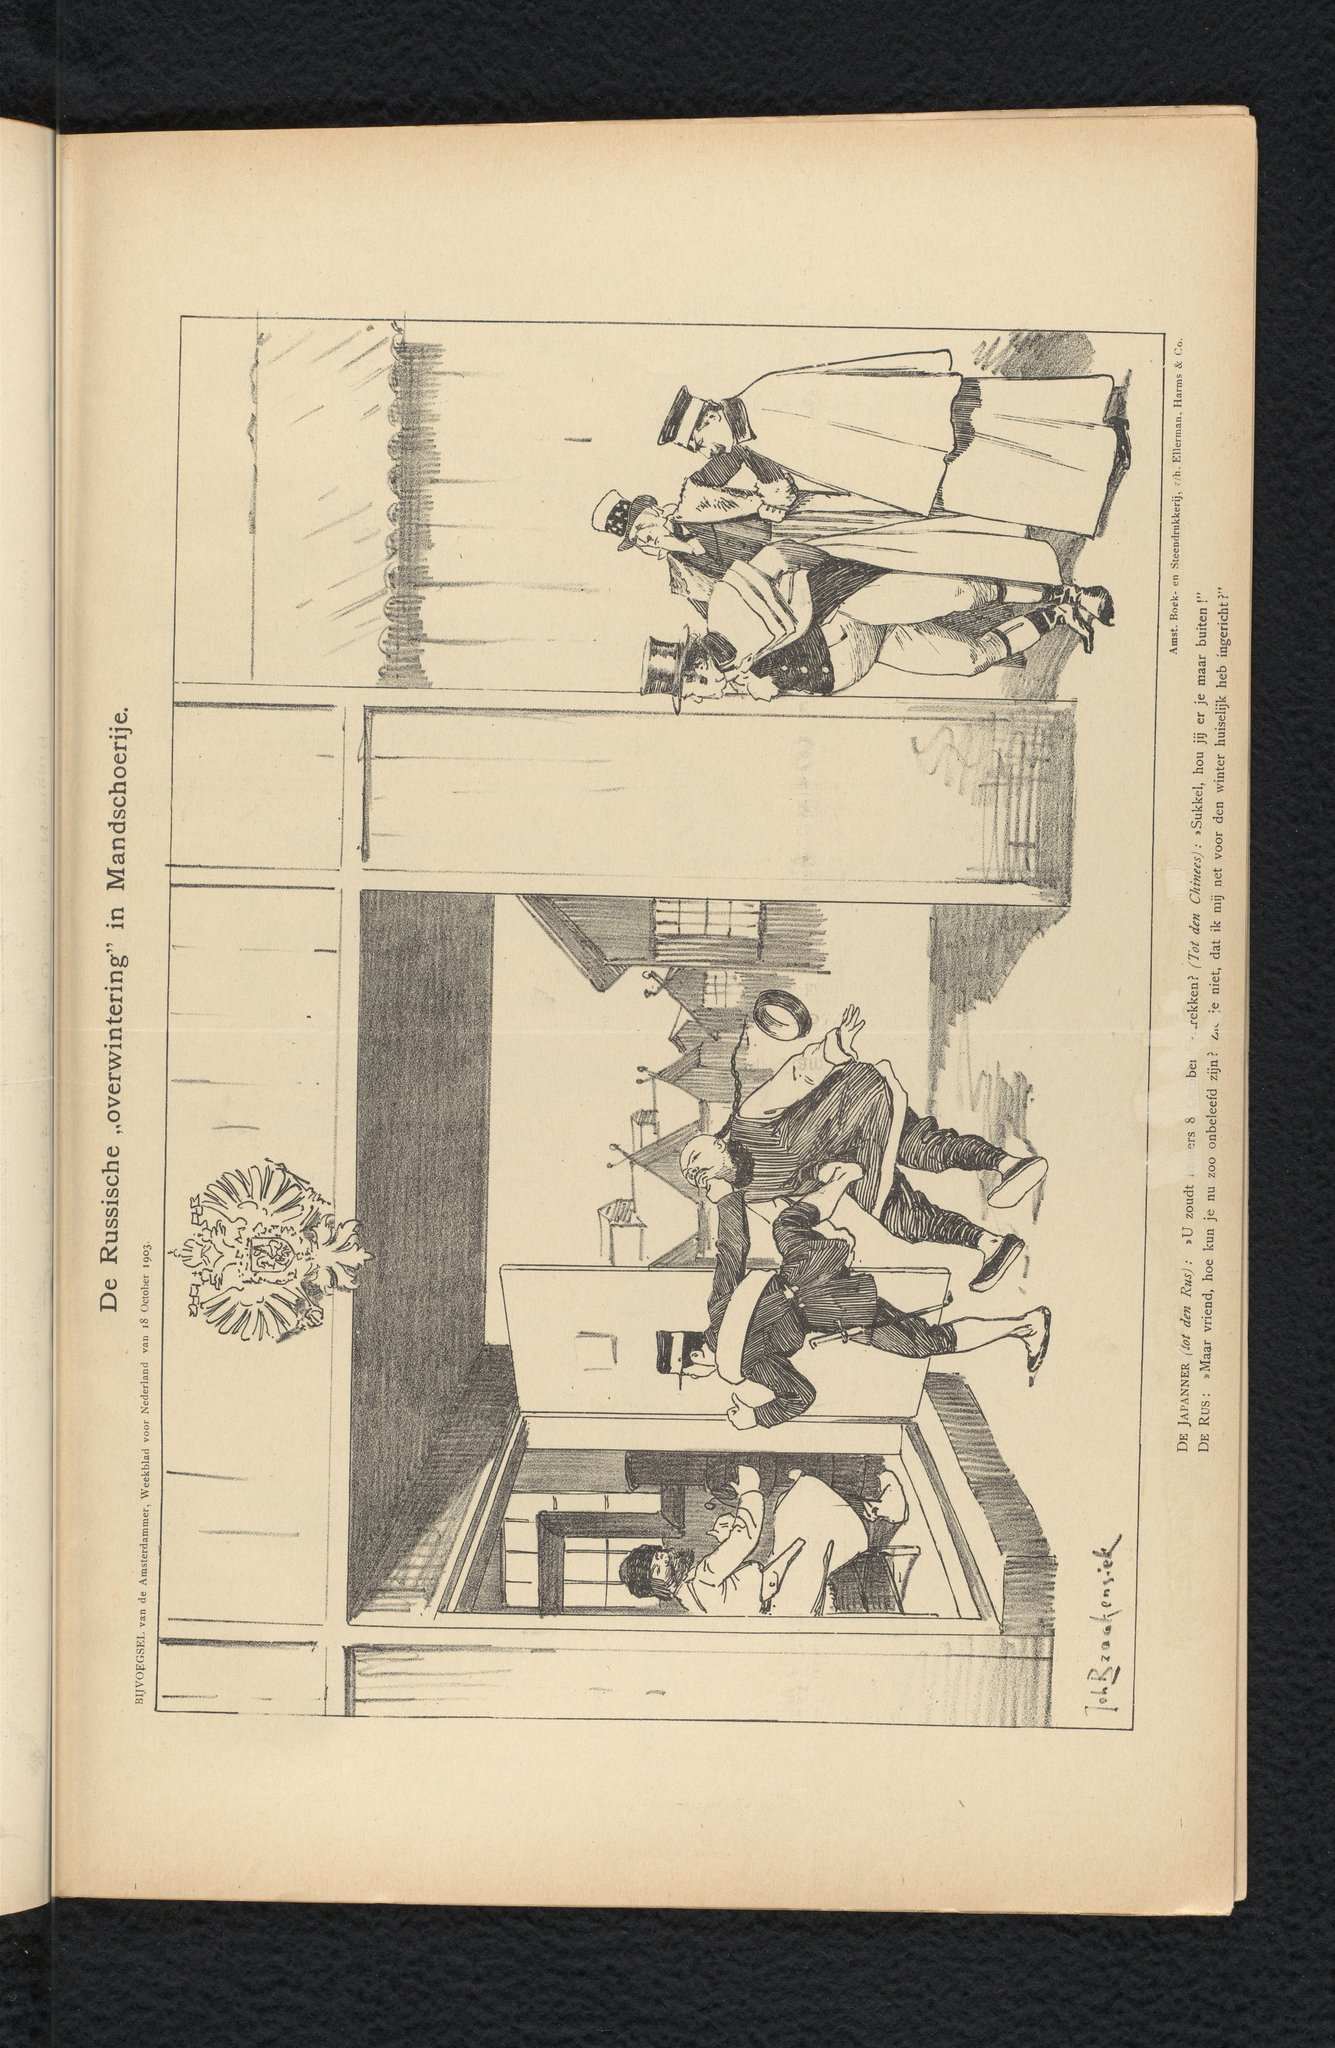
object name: cartoon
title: De Russische "overwintering" in Mandschoerije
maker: johan braakensiek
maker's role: draughtsman, print maker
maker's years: 1858-1940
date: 1903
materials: paper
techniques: lithograph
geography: amsterdam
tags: wilhelm ii (keizer van duitsland), personifications of countries, nations, states, districts, etc., kicking, warming oneself at a fire (or hearth, stove, fire-pan, brazier), political caricatures and satires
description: John Bull (Engeland), Uncle Sam (Verenigde Staten) en de Duitse keizer Wilhelm II kijken toe hoe Japan een Chinees wegschopt voor de deur van het warme huis van de Rus in Mantsjoerije.